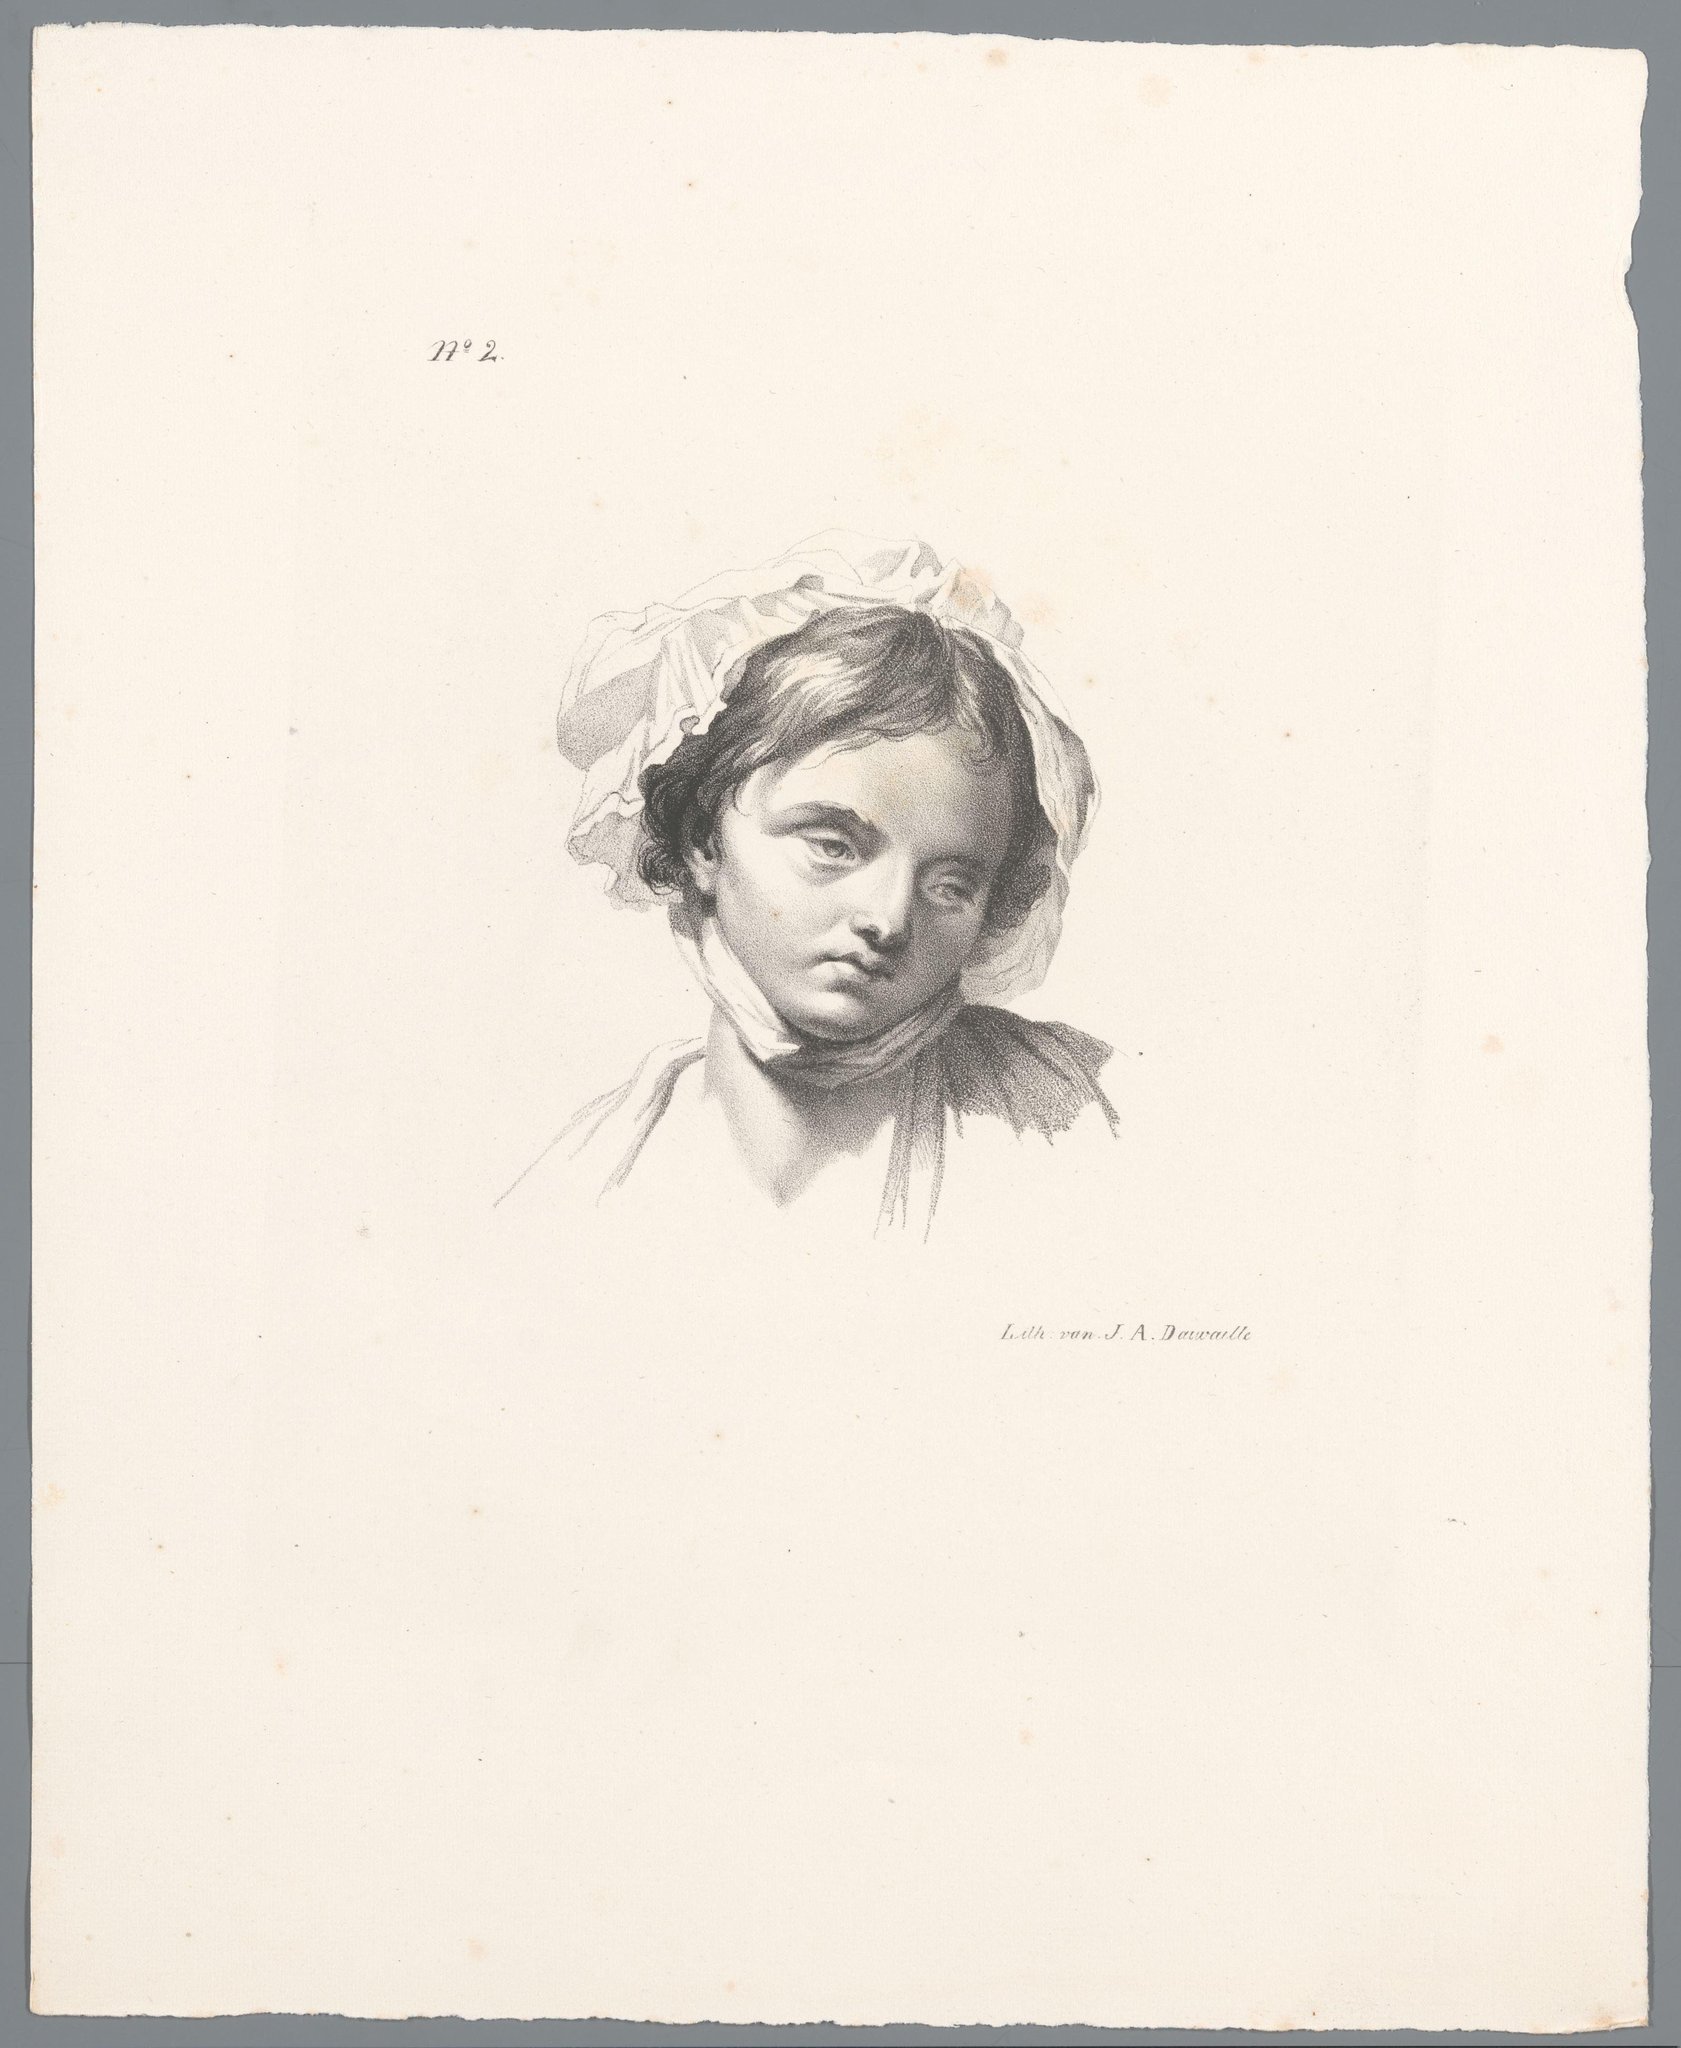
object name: print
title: Hartstochten na J.B. Greuze Nummer Twee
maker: jean augustin daiwaille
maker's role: draughtsman, print maker, printer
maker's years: 1786-1850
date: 1820-1830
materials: paper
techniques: lithograph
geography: amsterdam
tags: adolescent, young woman, maiden, head-gear: cap, looking downwards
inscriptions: collector's mark: Lugt 2228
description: 'Hartstochten na J.B. Greuze' bestaat uit twee of drie genummerde reeksen. (Sommige nummers komen drie keer voor op drie verschillende afbeeldingen.) Binnen deze omslag bevinden zich achttien verschillende afbeeldingen. Mogelijk heeft dit te maken met de twee momenten waarop Daiwaille de reeks uitgaf, ten tijden van zijn directeurschap aan de Rijksakademie in Amsterdam en daarna als zelfstandige. De omslag behoort waarschijnlijk bij een van deze twee series. Zie Marres-Schretlen in het Bulletin van het Rijksmuseum.